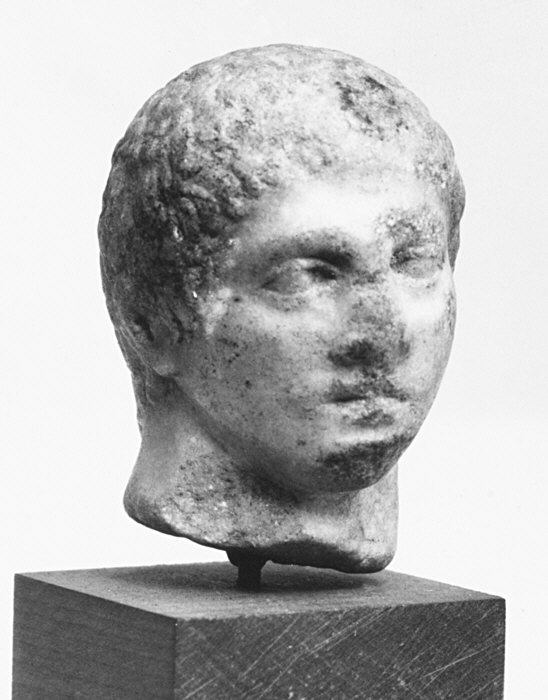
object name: head of a youth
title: Marble head of a youth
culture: greek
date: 400-301 BCE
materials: marble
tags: heads,men